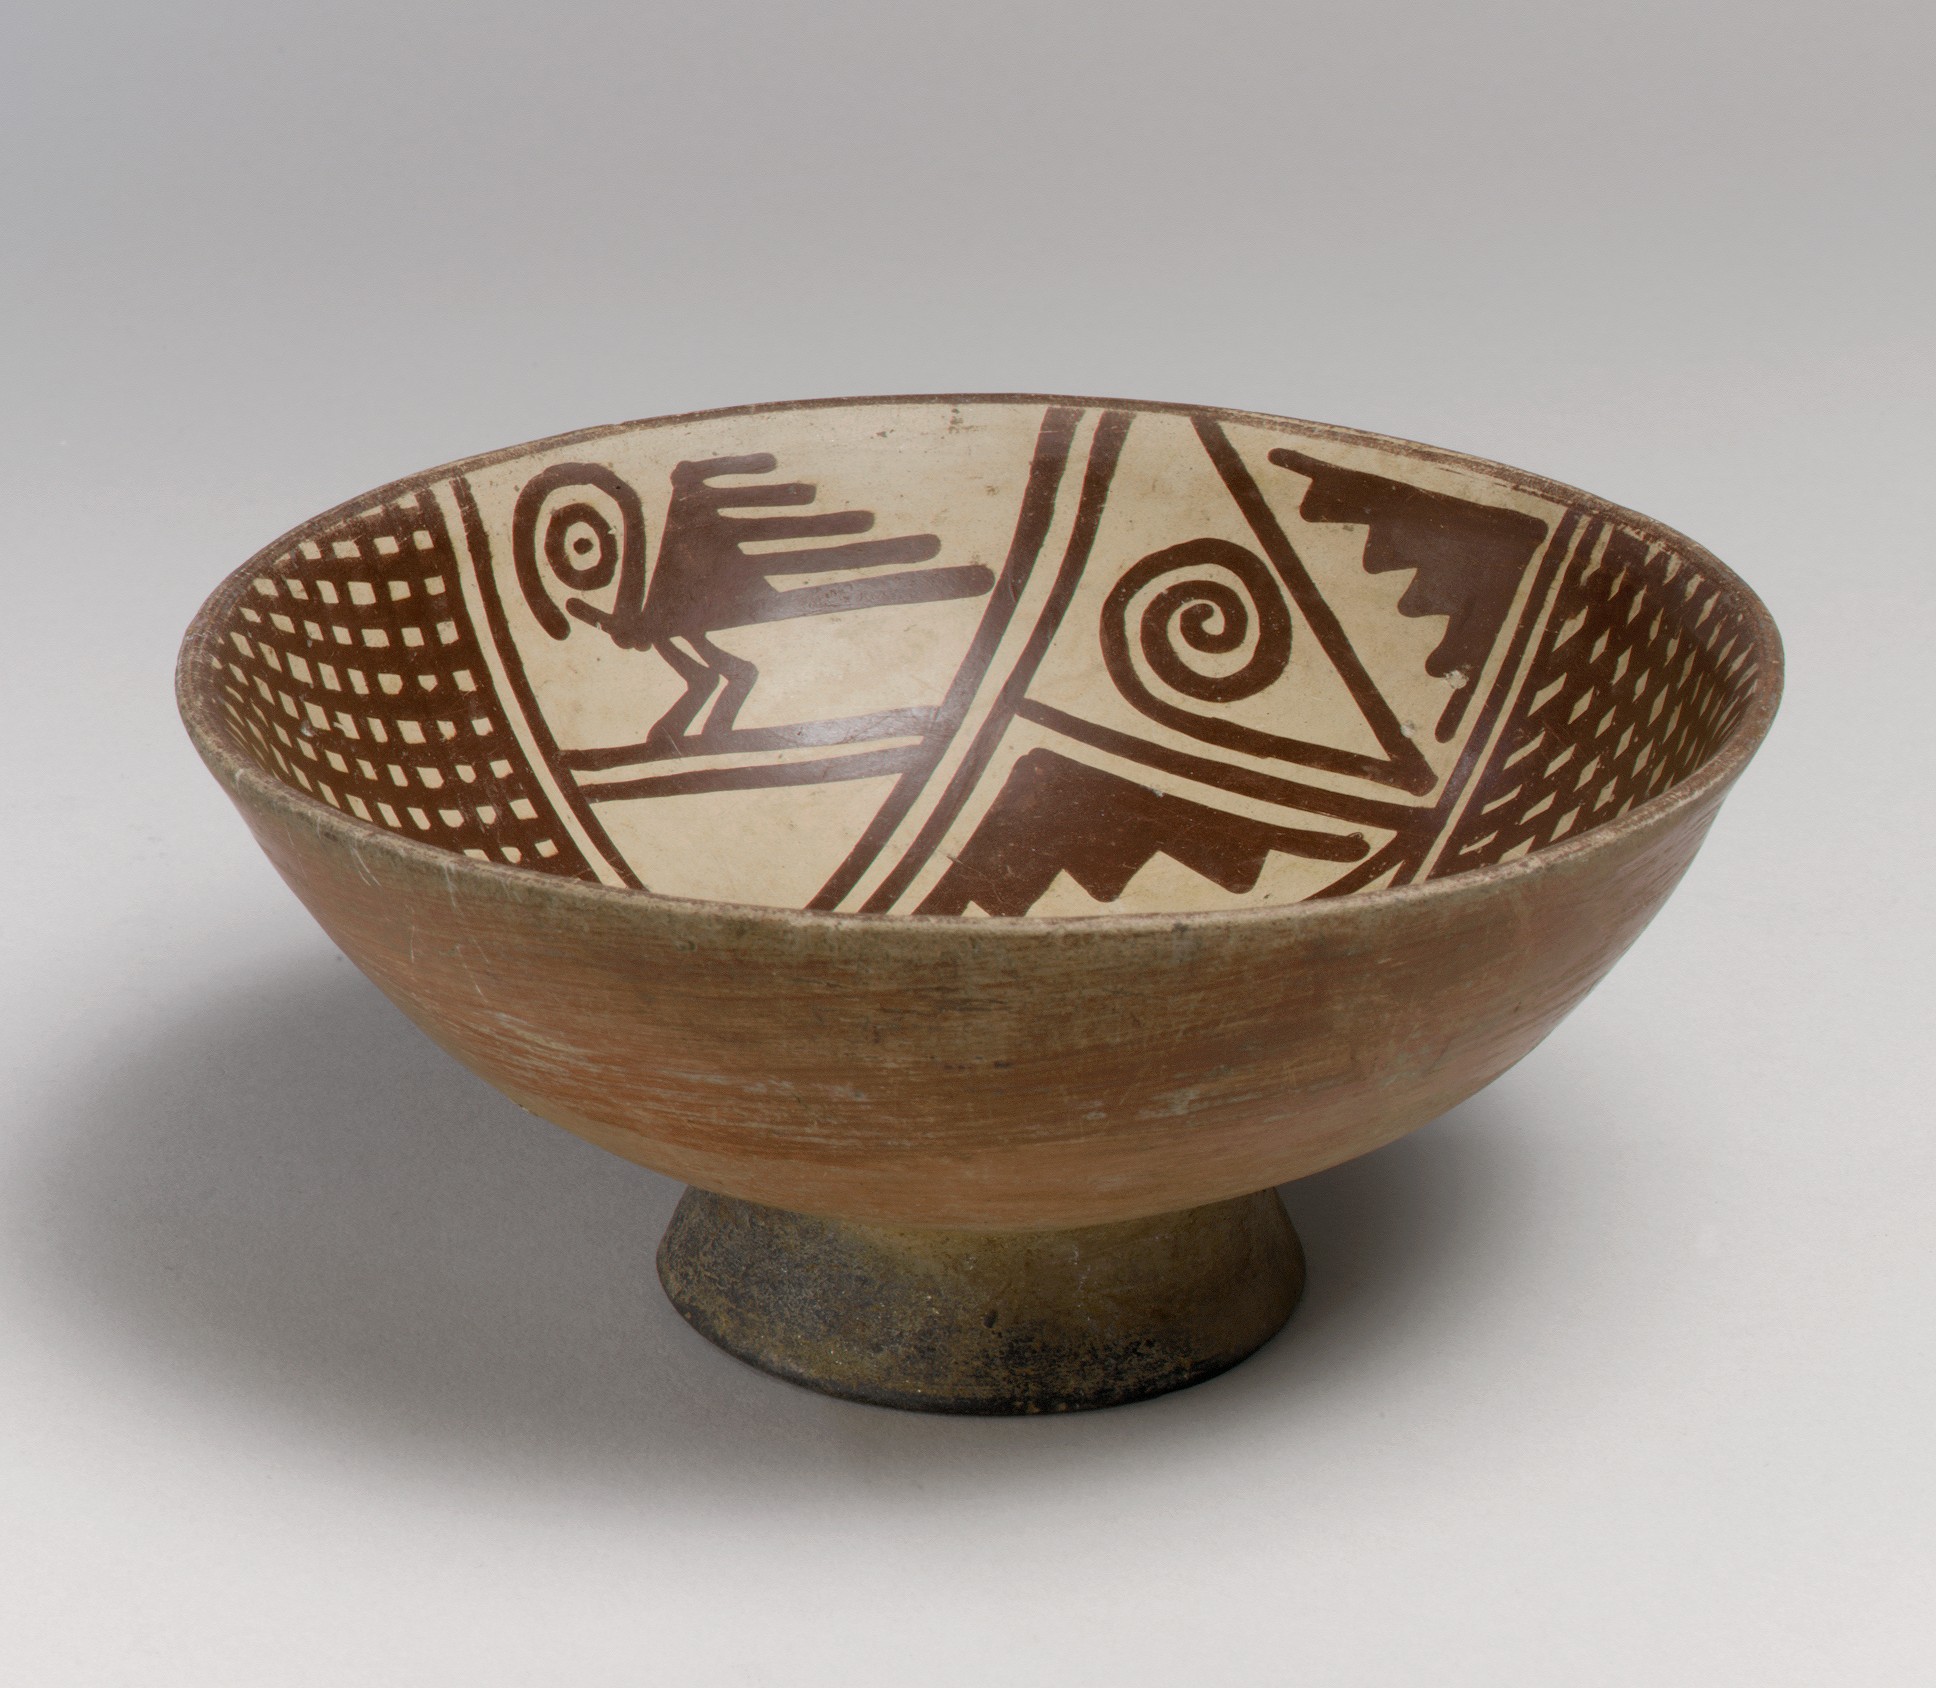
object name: bowl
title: Pedestal Bowl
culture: carchi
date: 1201-1600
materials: ceramic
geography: colombia